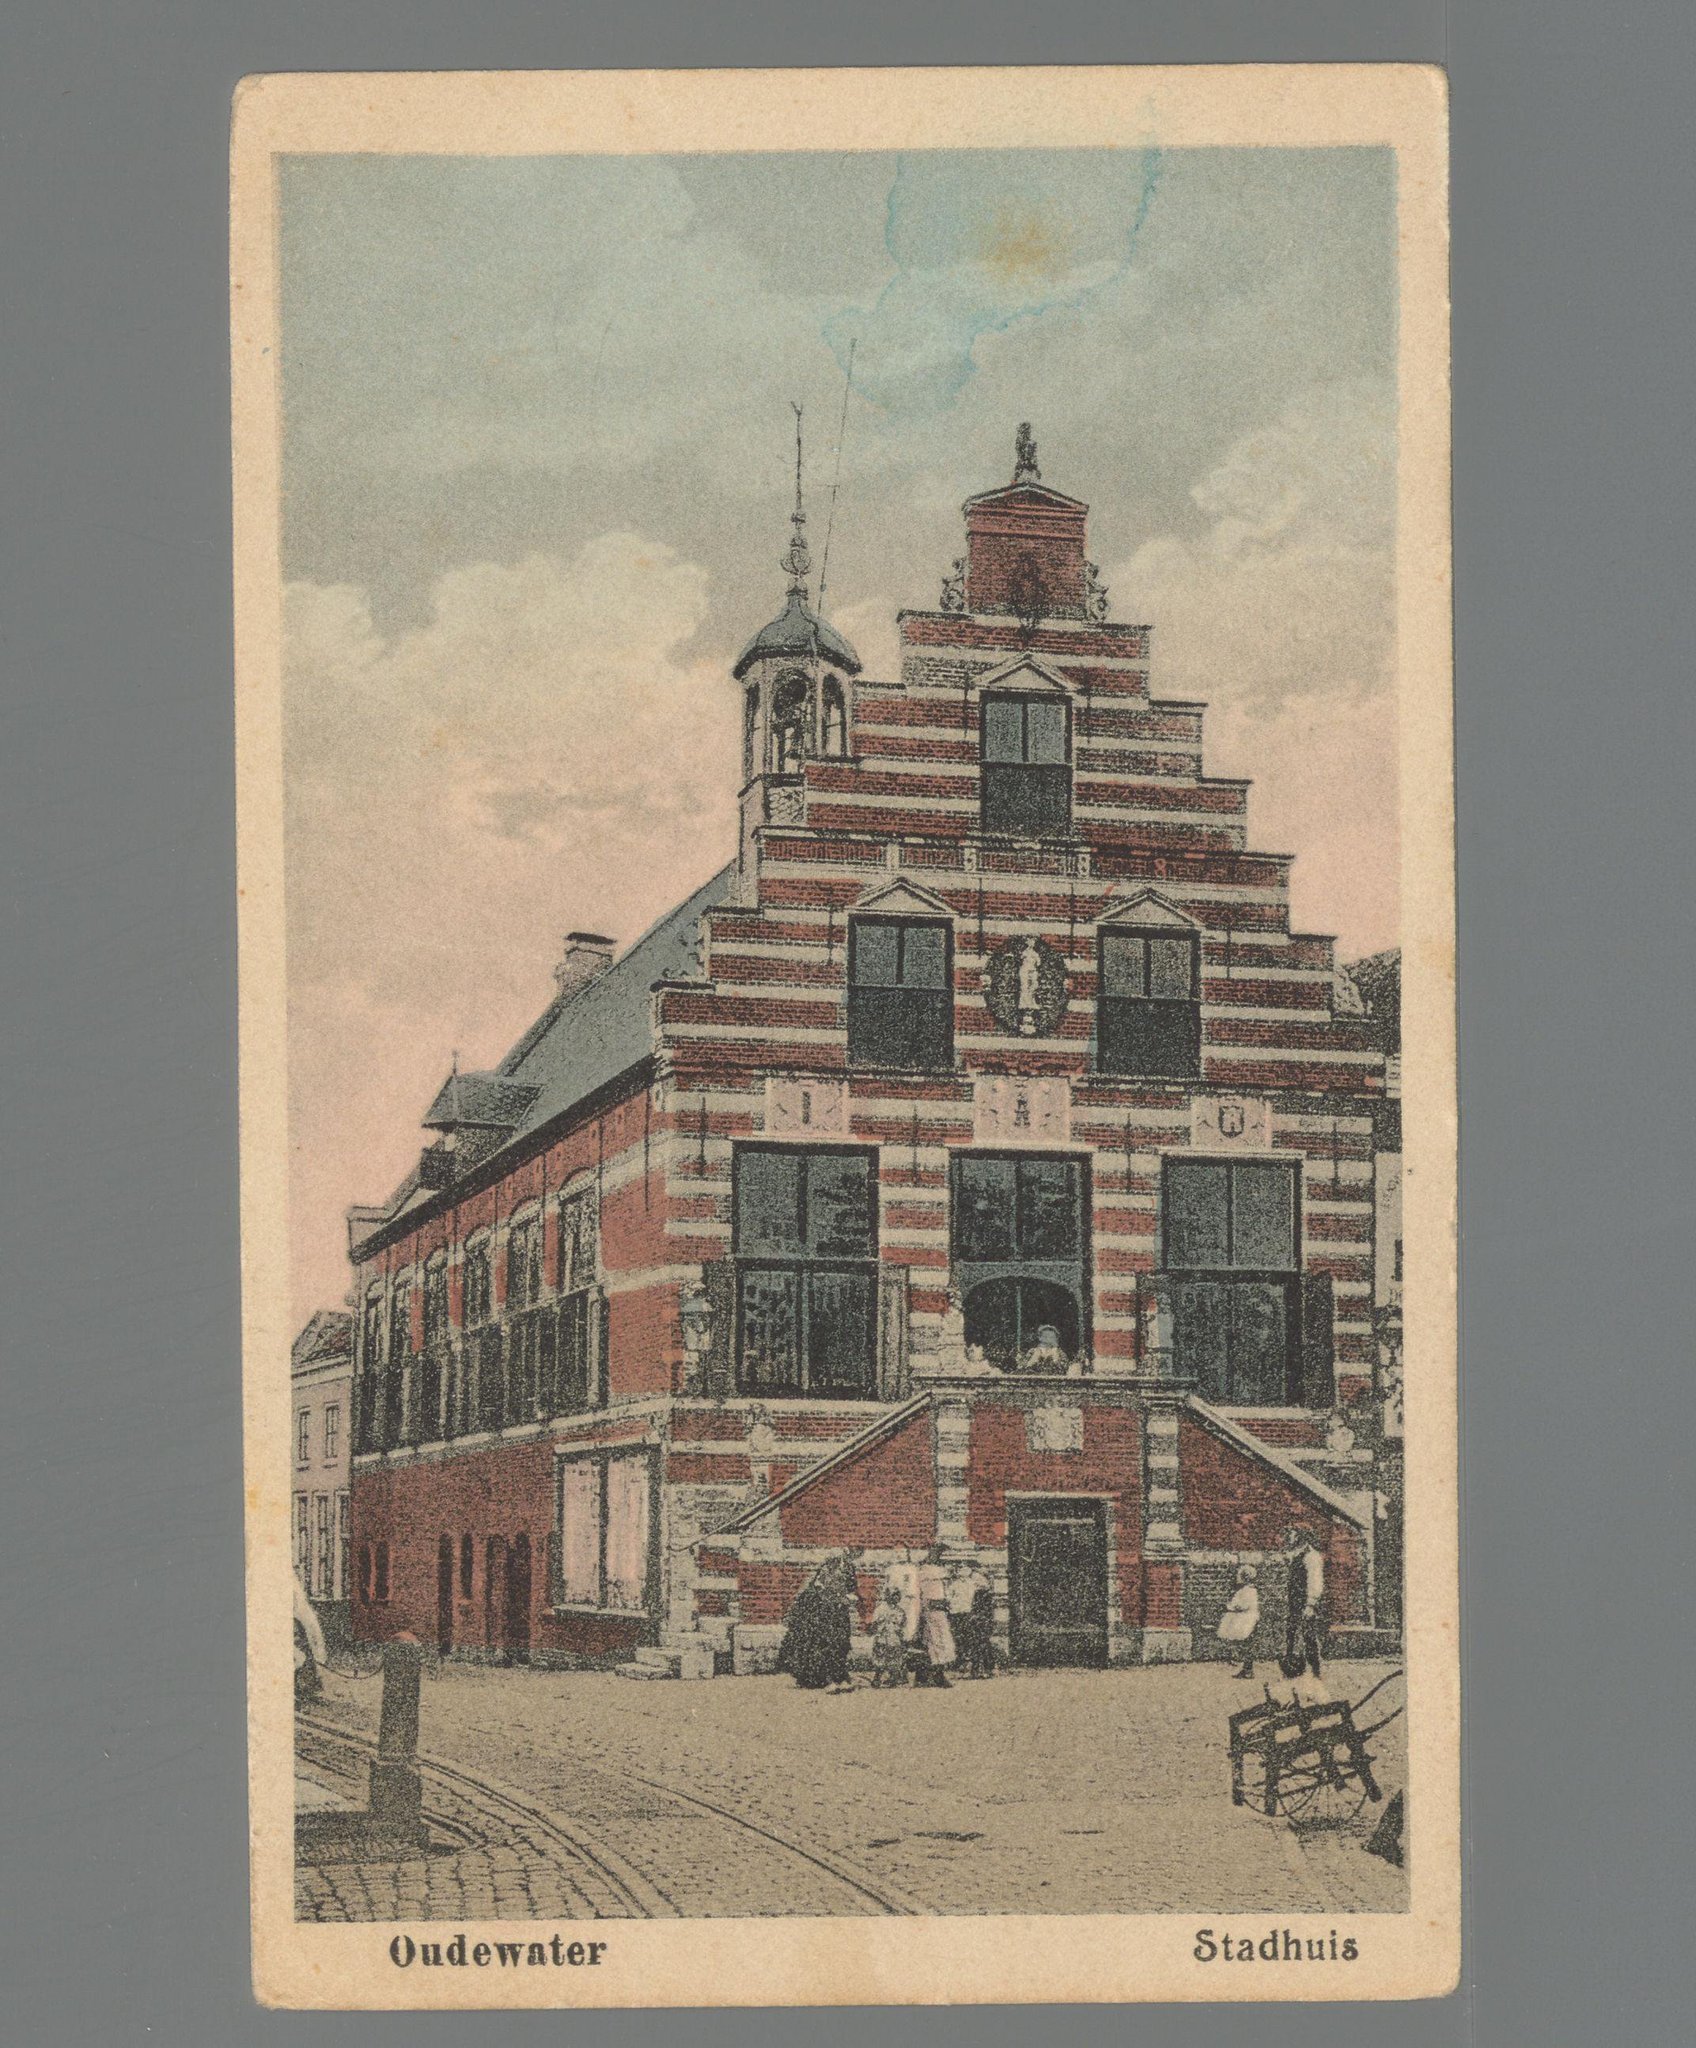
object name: ansichtkaart, prentbriefkaart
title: Oudewater. Stadhuis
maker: Anonymous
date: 1913-1930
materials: cardboard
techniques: photograph, lithograph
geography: oudewater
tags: townhall